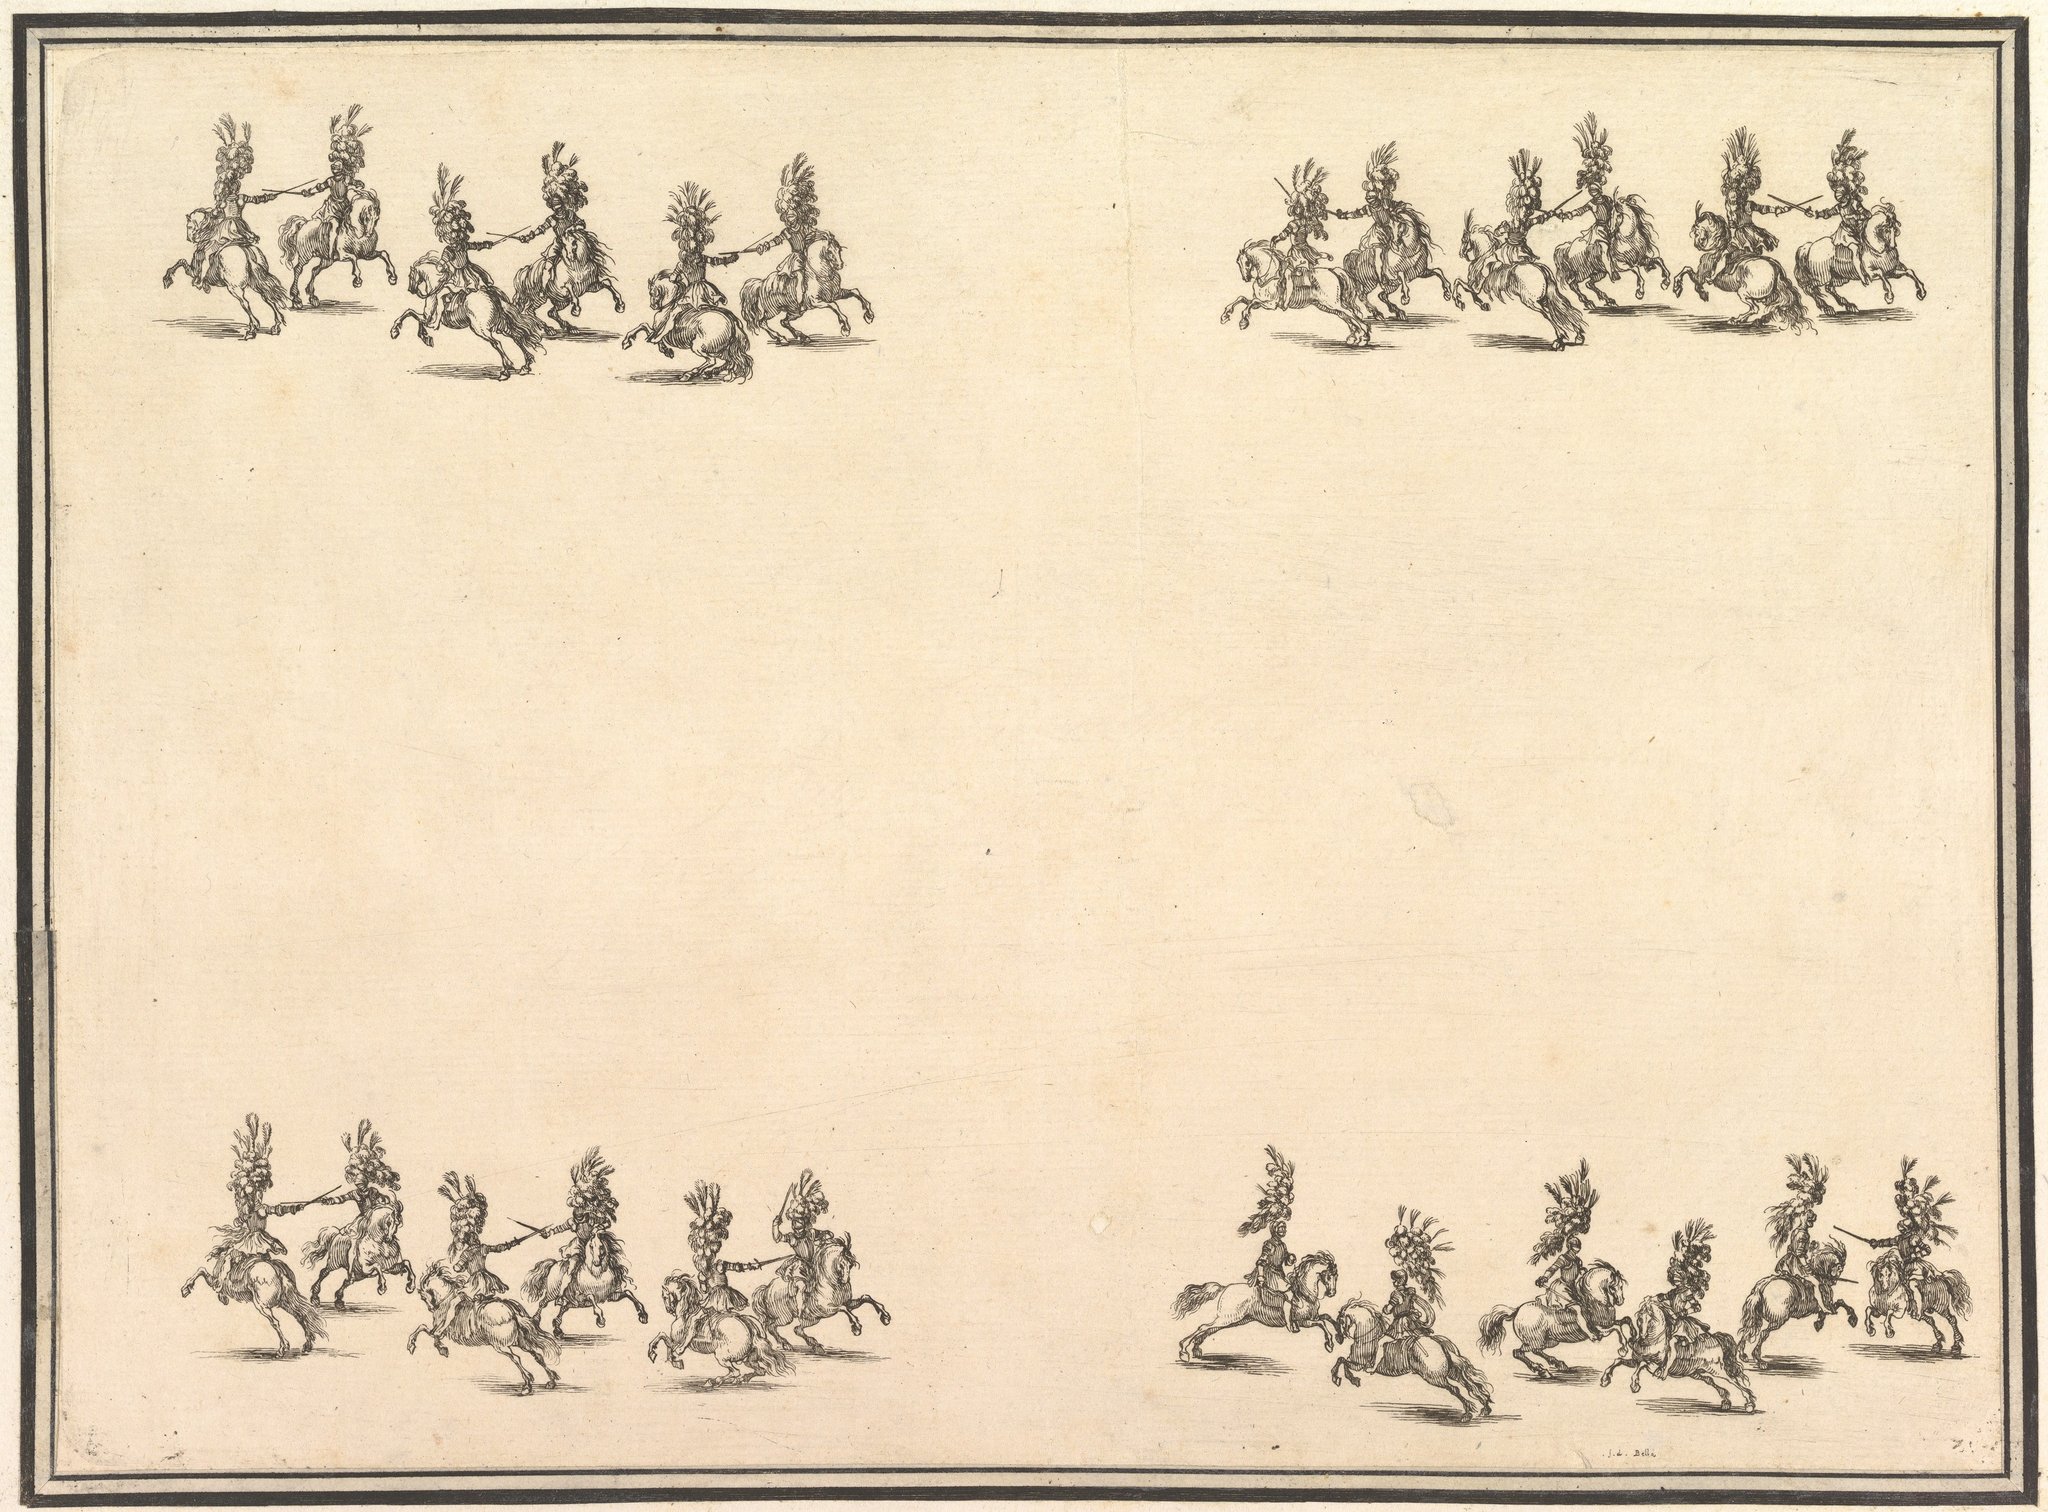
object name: print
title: Twenty-four riders dueling with swords in four groups, with two groups in lines at the top and bottom of the page, from "La gara delle Stagioni"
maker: stefano della bella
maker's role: artist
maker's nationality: italian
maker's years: 1610-1664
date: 1652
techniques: etching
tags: human figures,swords,horses